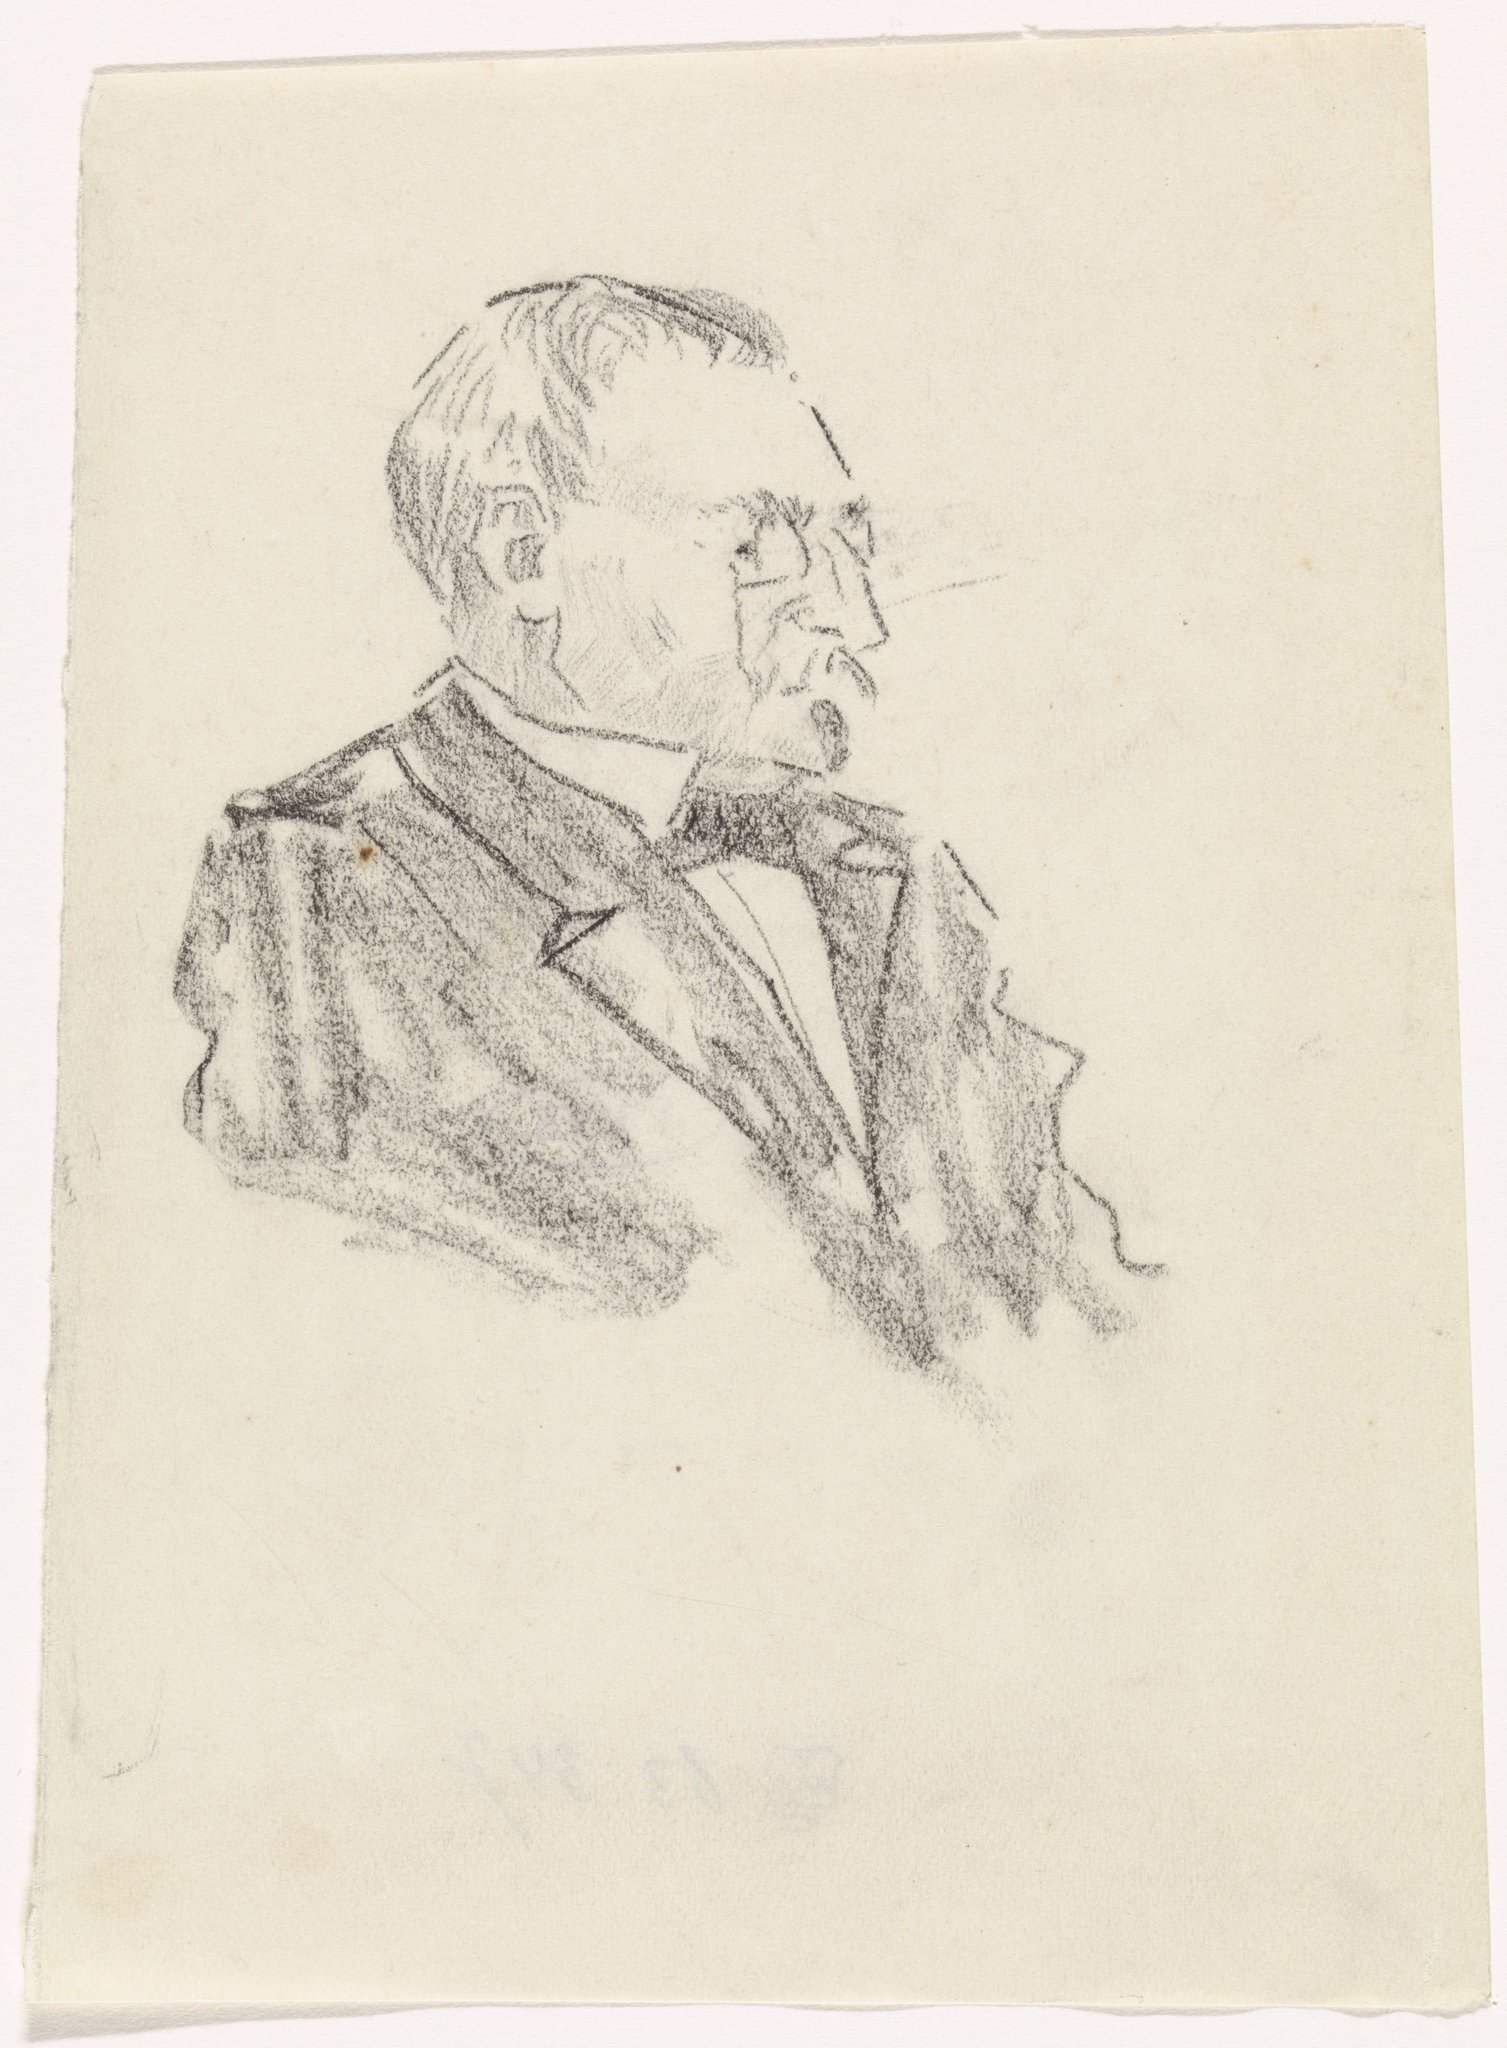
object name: drawing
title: Portret van een heer, naar rechts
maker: gerrit willem dijsselhof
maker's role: designer, draughtsman, print maker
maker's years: 1866-1924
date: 1876-1924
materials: chalk, paper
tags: anonymous historical person portrayed alone